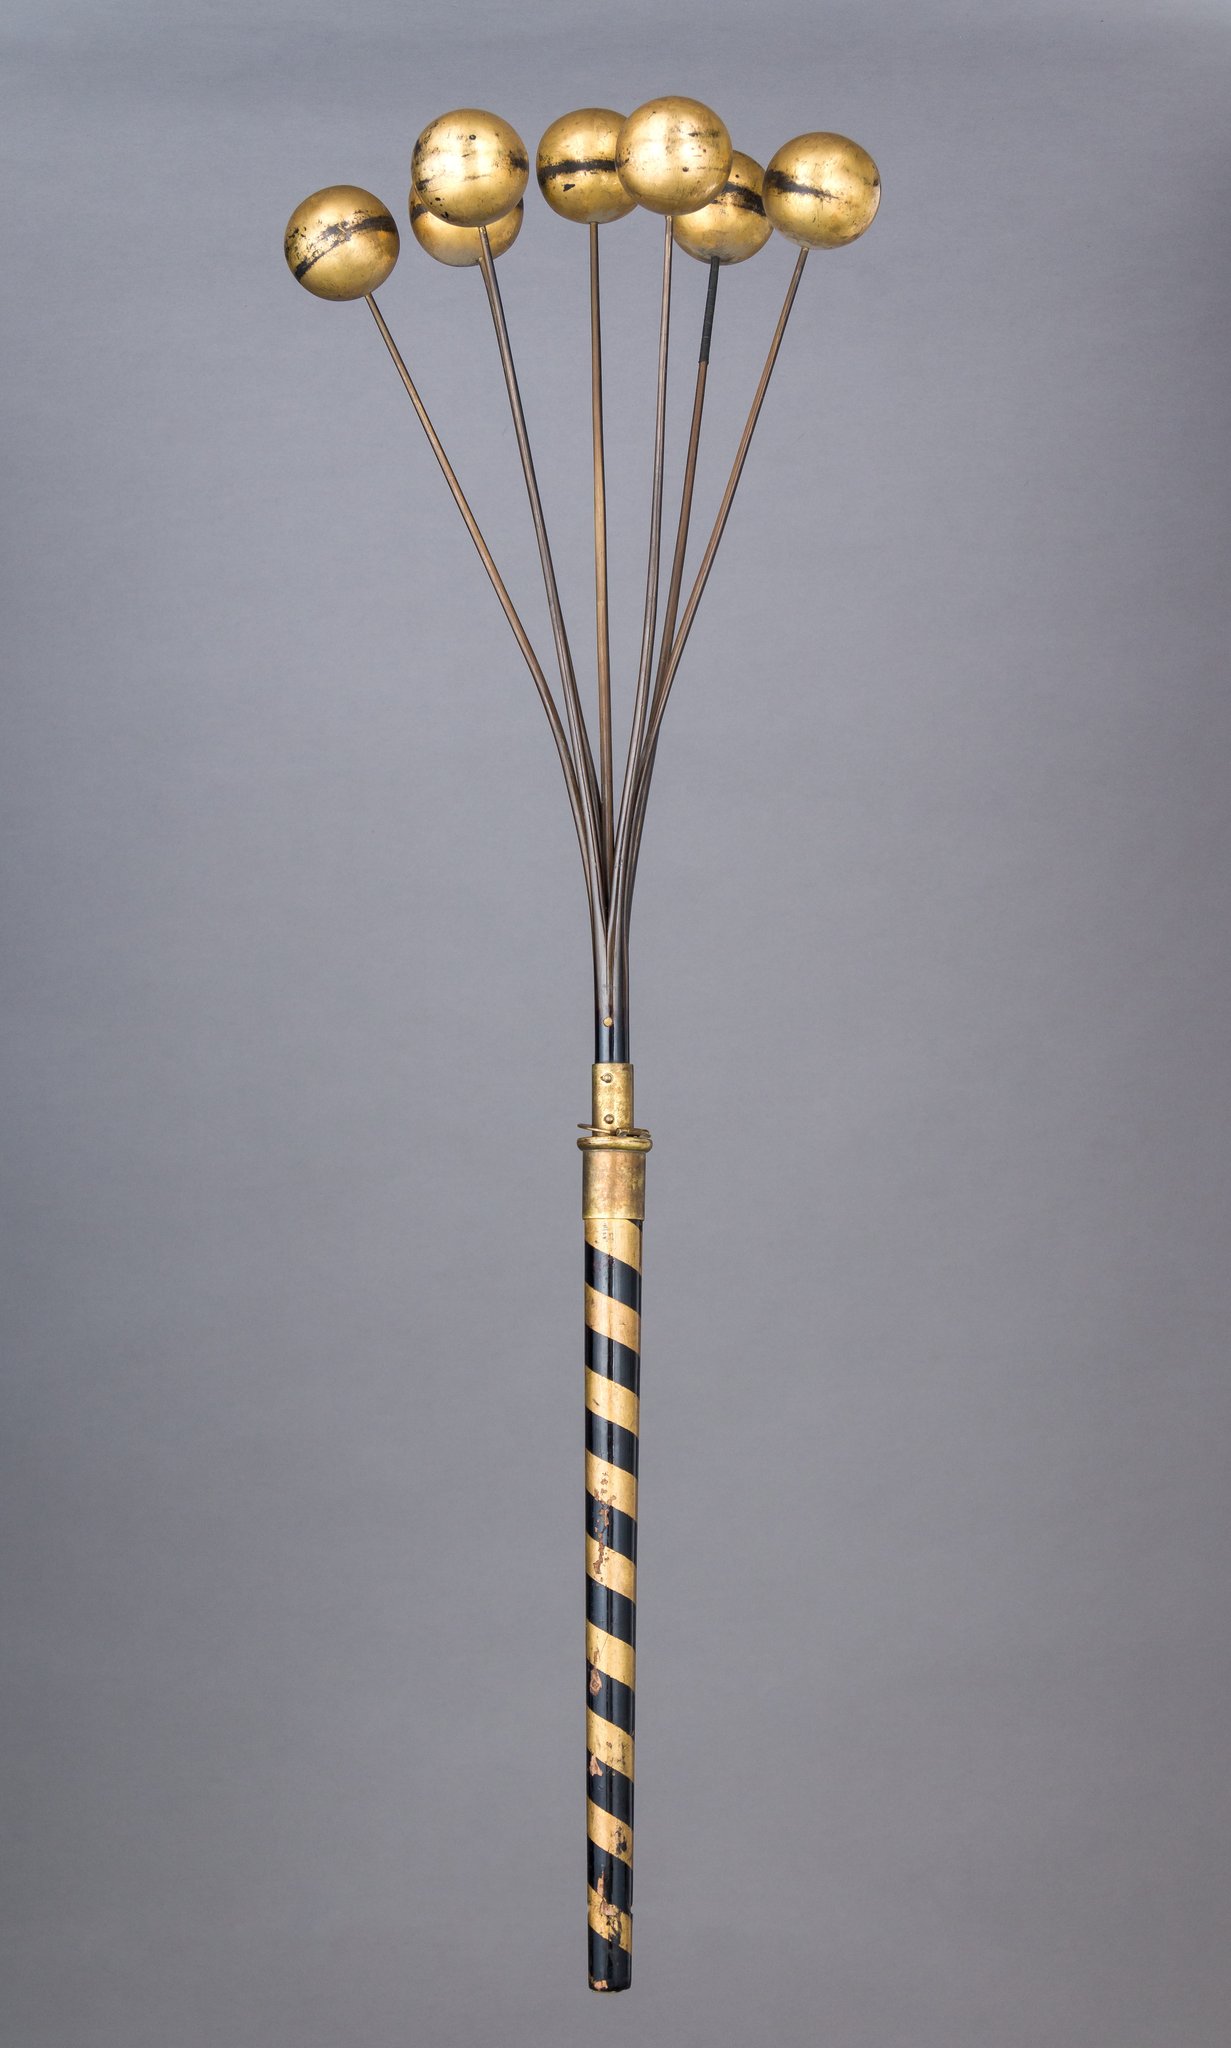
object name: field ensign i sashimono i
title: Field Ensign (Sashimono)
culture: japanese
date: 1701-1800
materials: bone, copper, gold, lacquer, wood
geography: japan